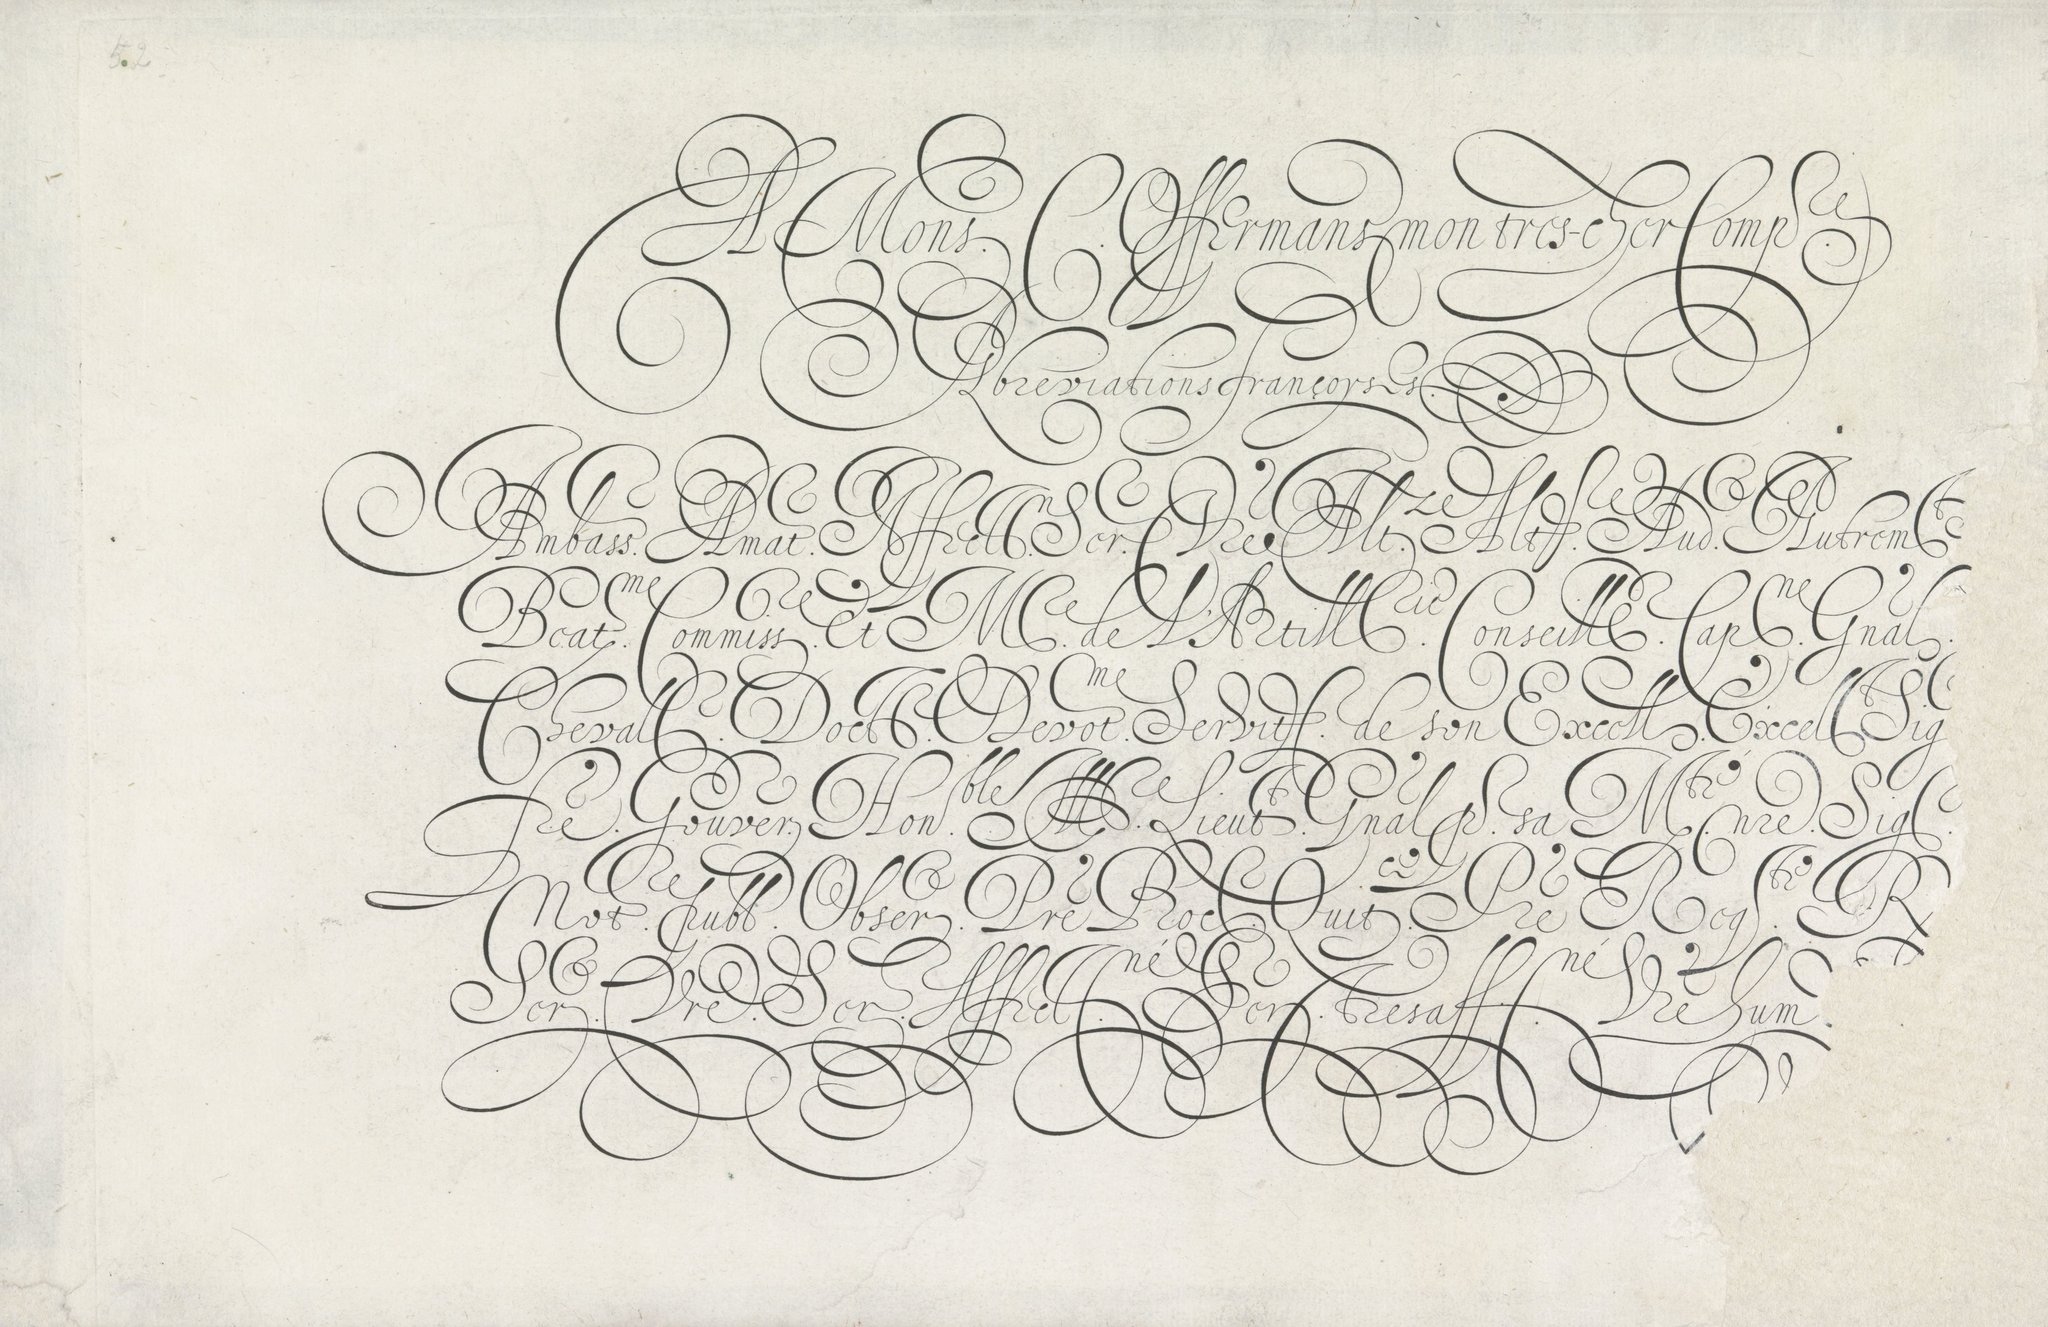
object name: print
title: Schrijfvoorbeeld: A mons. C. Offermans (...)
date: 1605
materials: paper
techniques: engraving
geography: rotterdam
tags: calligraphy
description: Schrijfvoorbeeld met de aanhef: A mons. C. Offermans ... Daaronder zes regels tekst in het Latijn, voornamelijk bestaande uit afkortingen: Ambass. Amat. ... De prent maakt deel uit van een album.